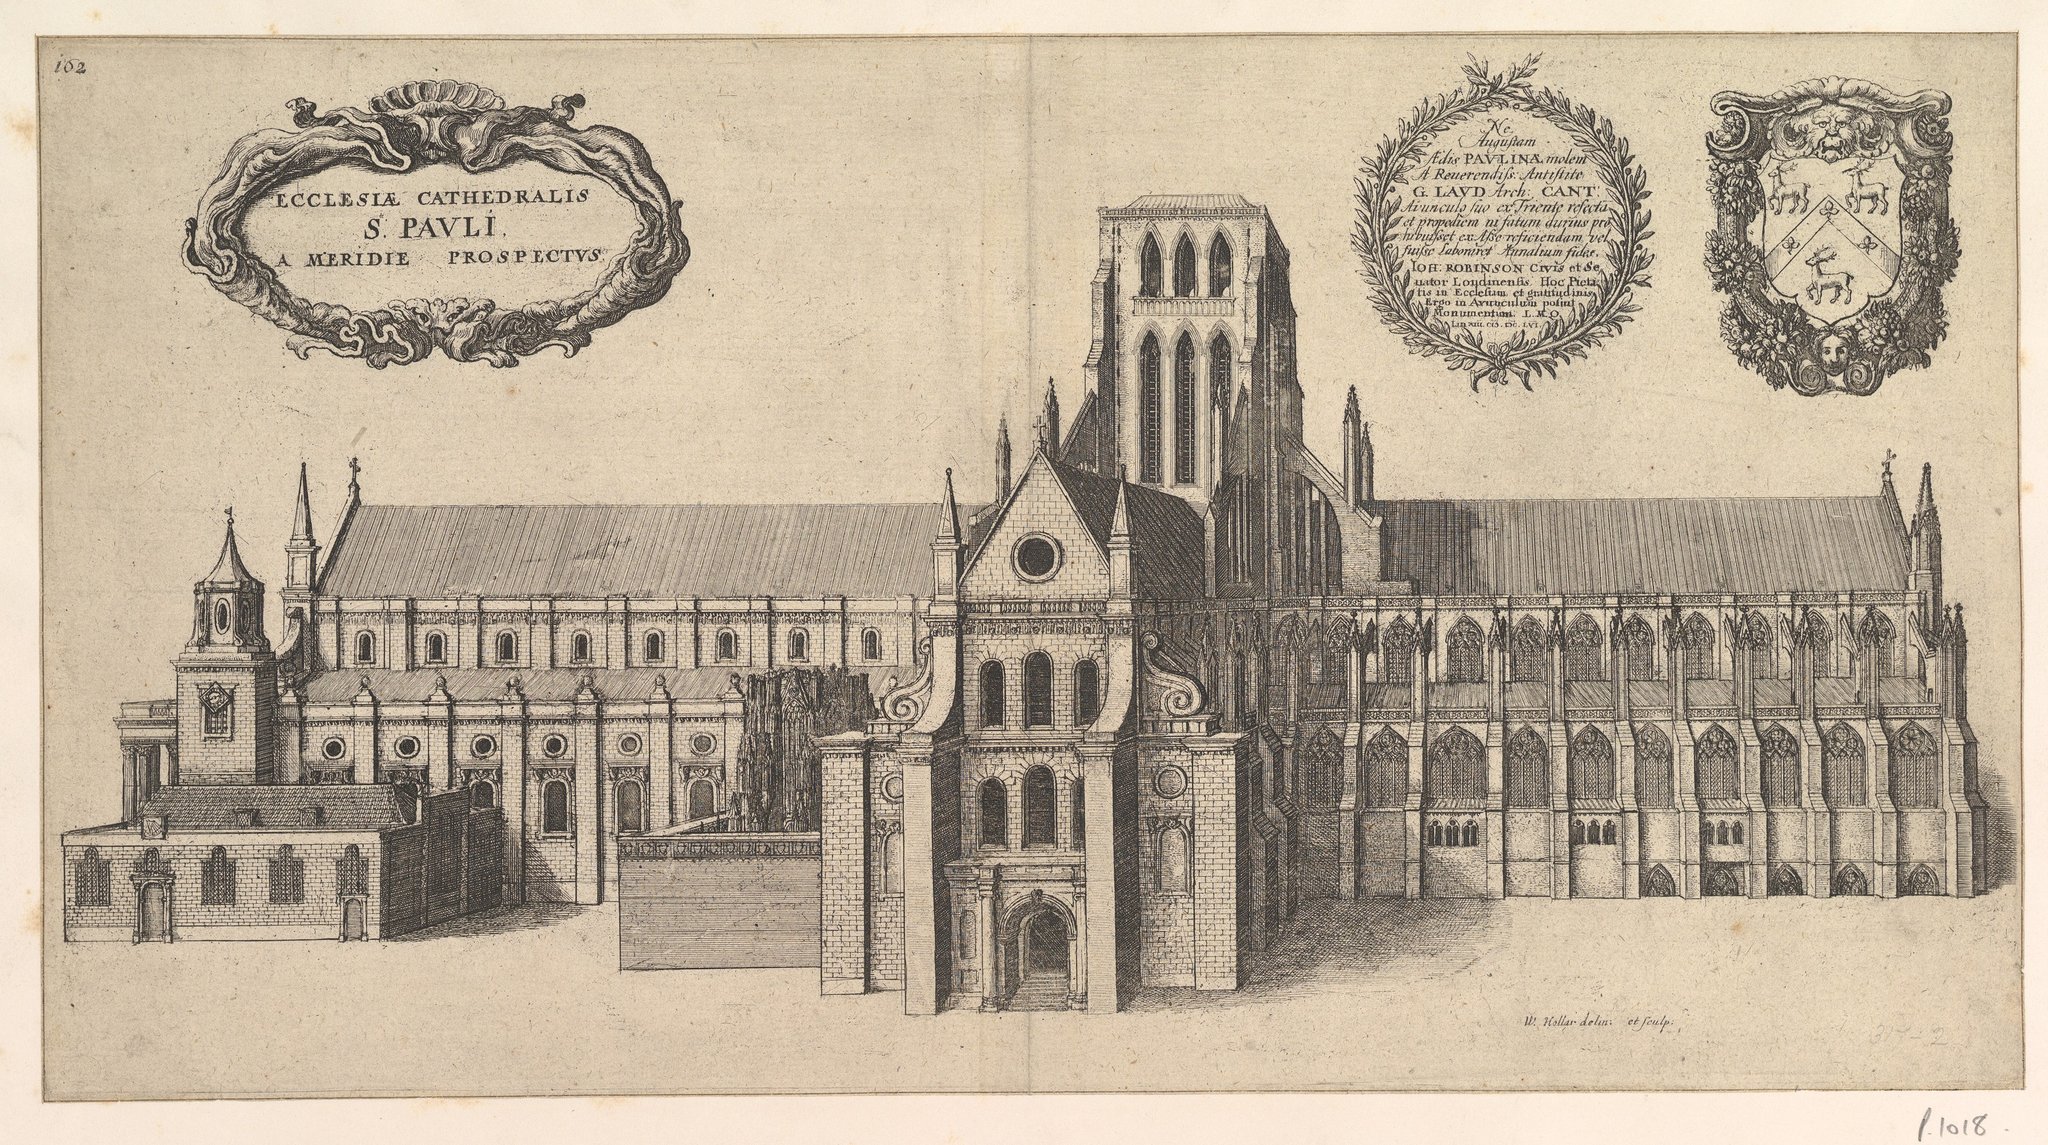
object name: print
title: Saint Paul's, South side (Ecclesiae Cathedralis St. Pauli, A Meridi Prospectus), from "The History of St. Paul's Cathedral in London"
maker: wenceslaus hollar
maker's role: artist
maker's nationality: bohemian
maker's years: 1607-1677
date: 1658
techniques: etching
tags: churches,coat of arms